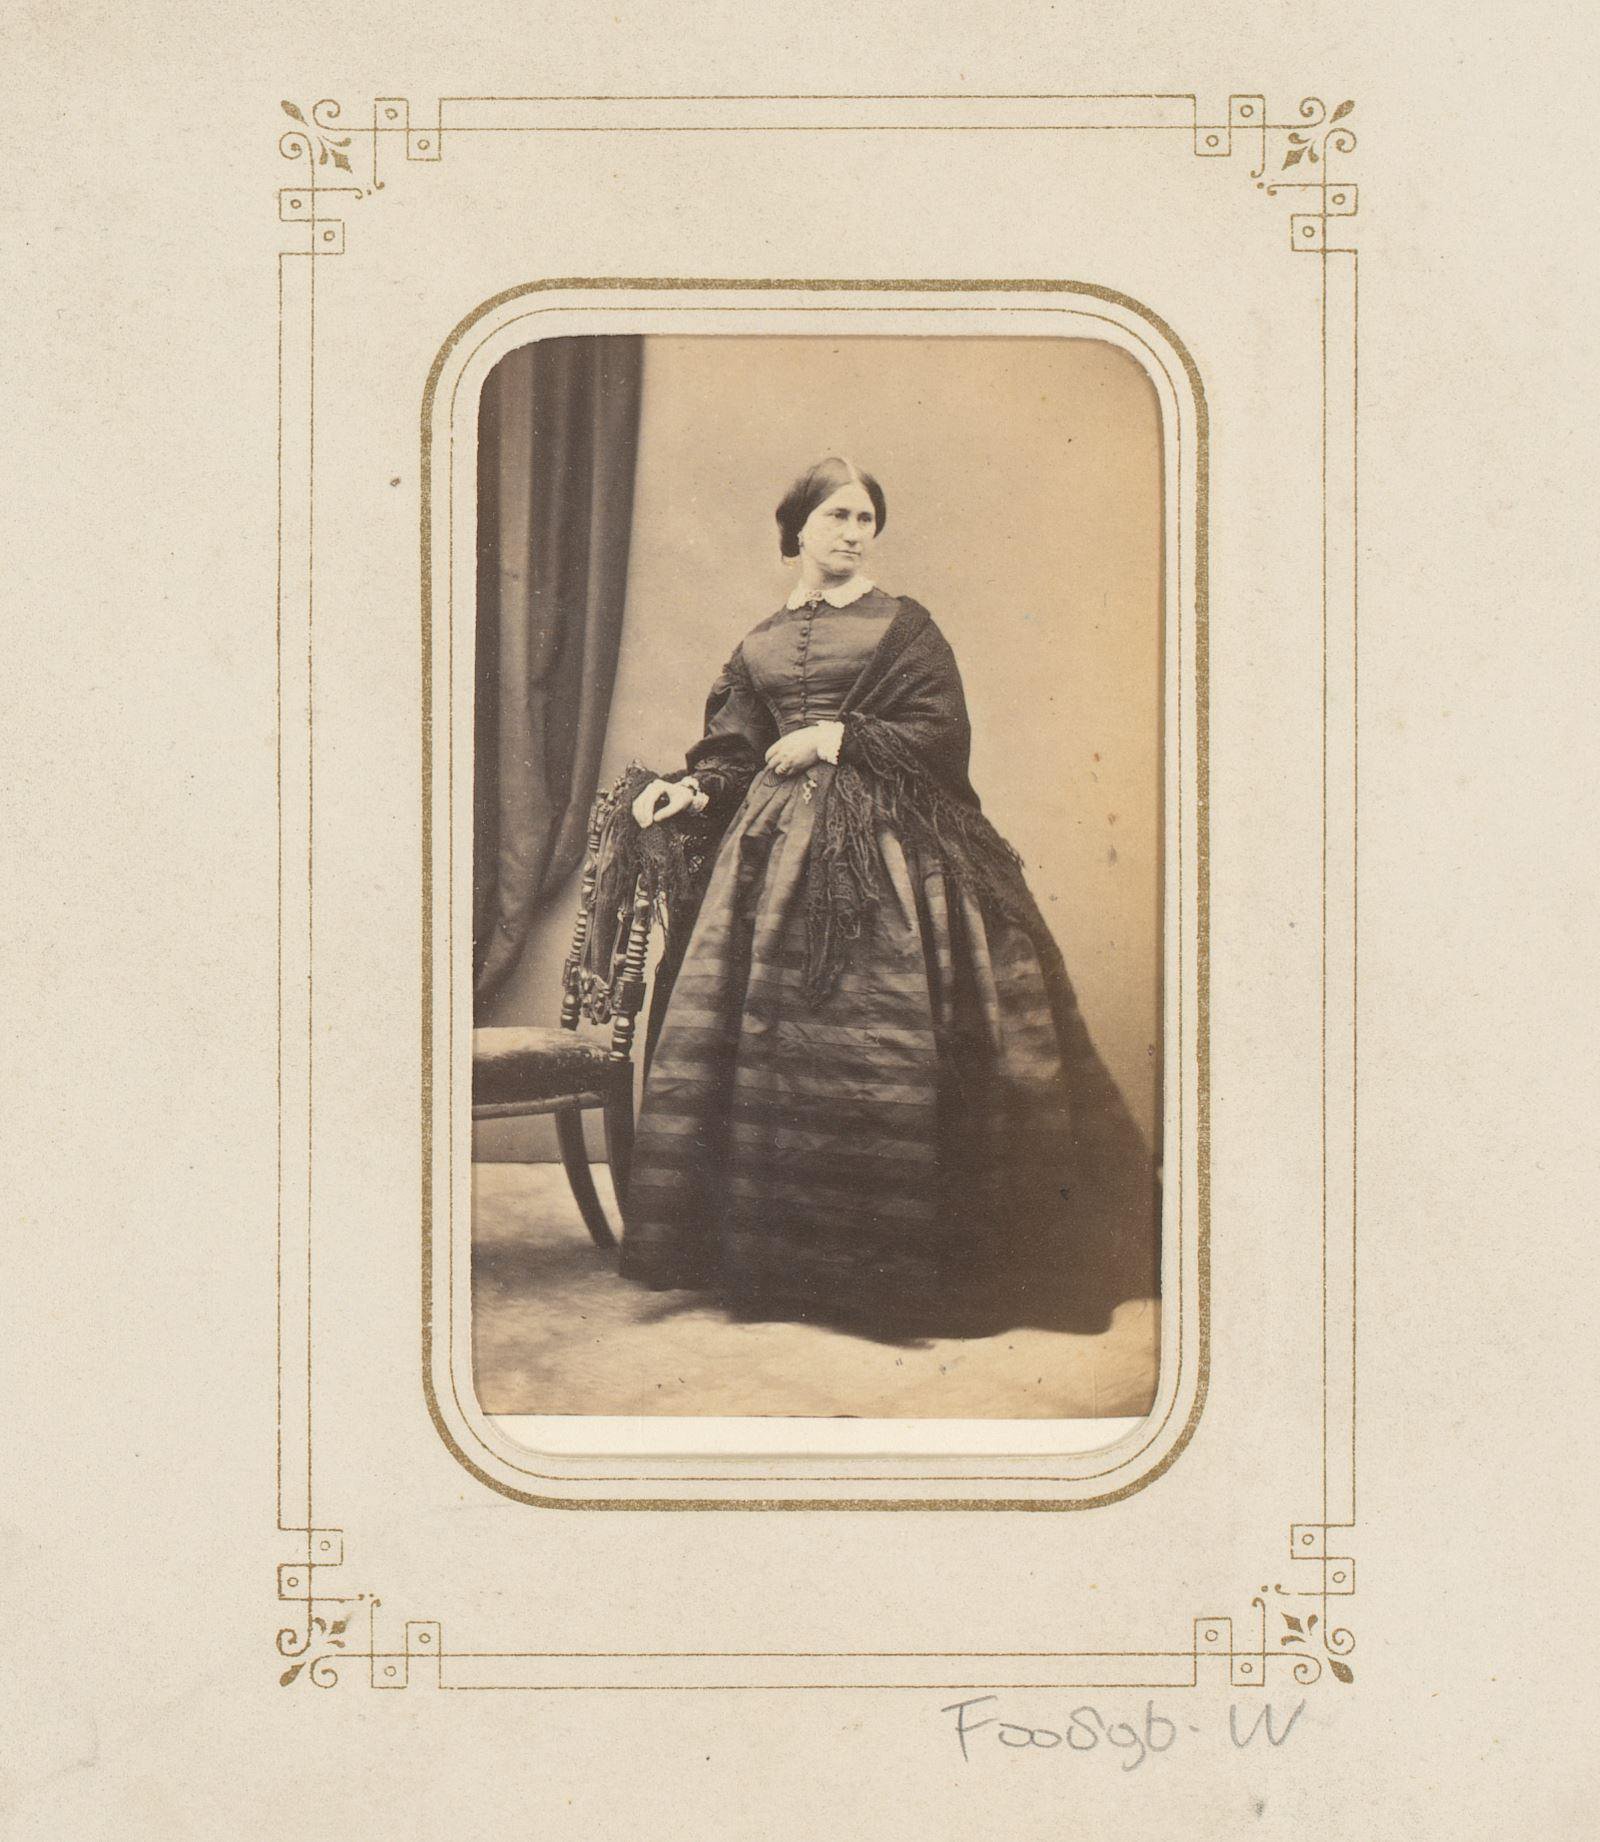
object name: photograph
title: Portret van een vrouw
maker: Anonymous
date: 1860-1890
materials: cardboard, photographic support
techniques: albumen print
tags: historical persons, standing figure - aa - female human figure